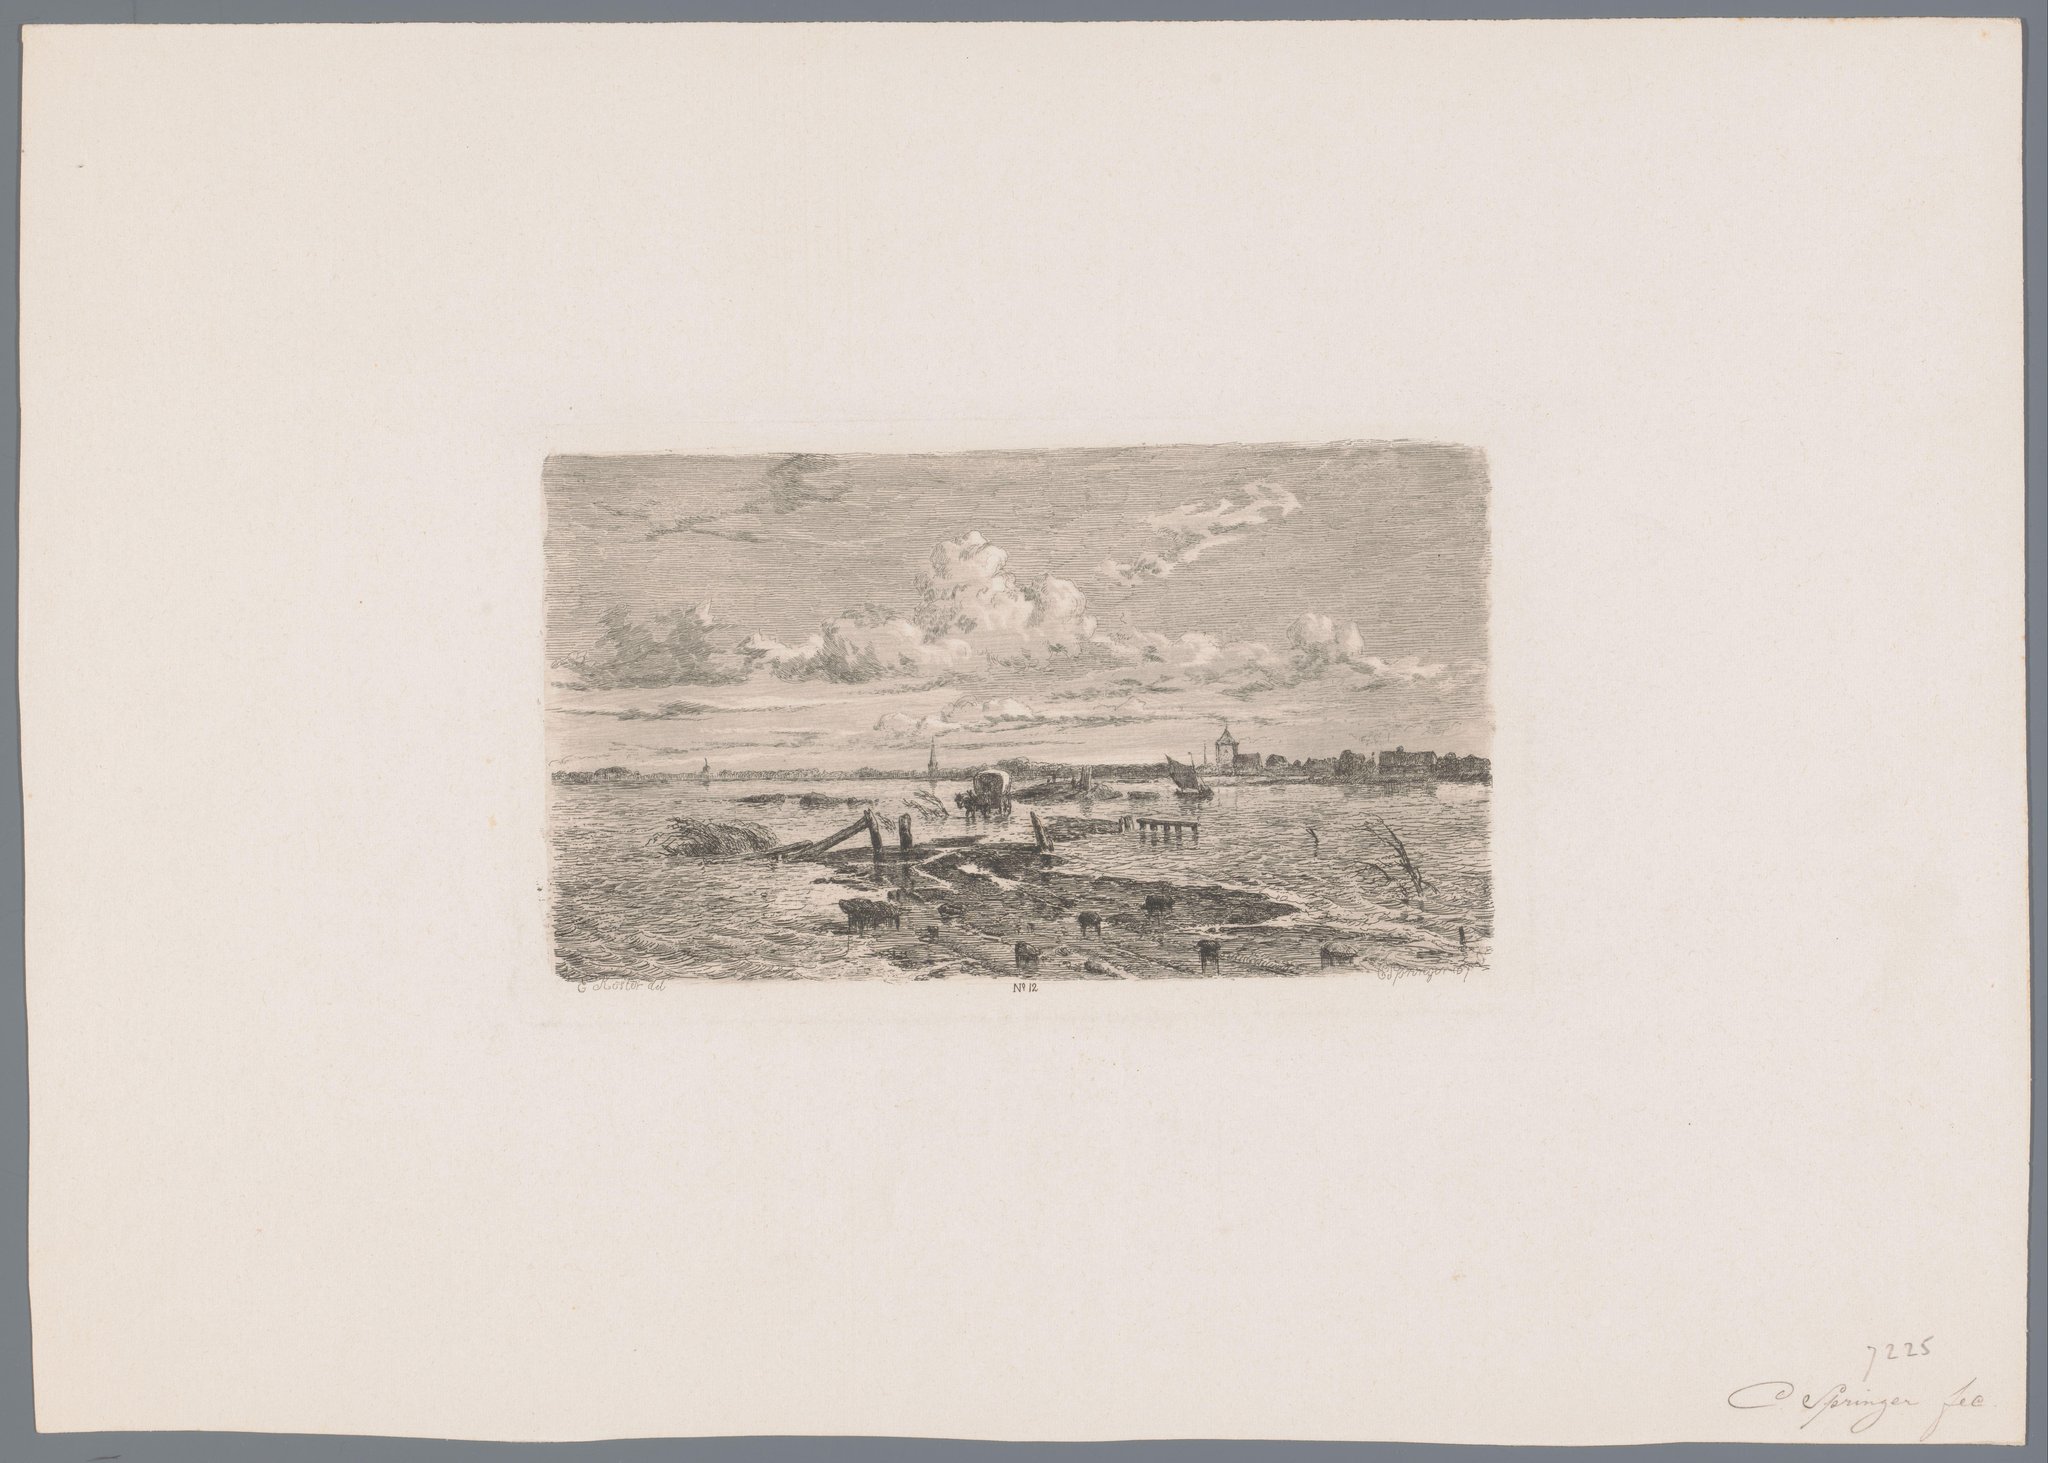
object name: print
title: Grindweg tusschen Oss en Lith, 24 Maart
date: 1855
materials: paper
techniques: etching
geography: netherlands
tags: flood, oss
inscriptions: collector's mark: Lugt 2228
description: Een huifkar bij de weggespoelde weg tussen Oss en Lith, 24 maart 1855. Onderdeel van de reeks van 24 prenten over de watersnood van maart 1855, door leden van het genootschap Arti et Amicitiae. Uitgave ten behoeve van de slachtoffers van de watersnood.